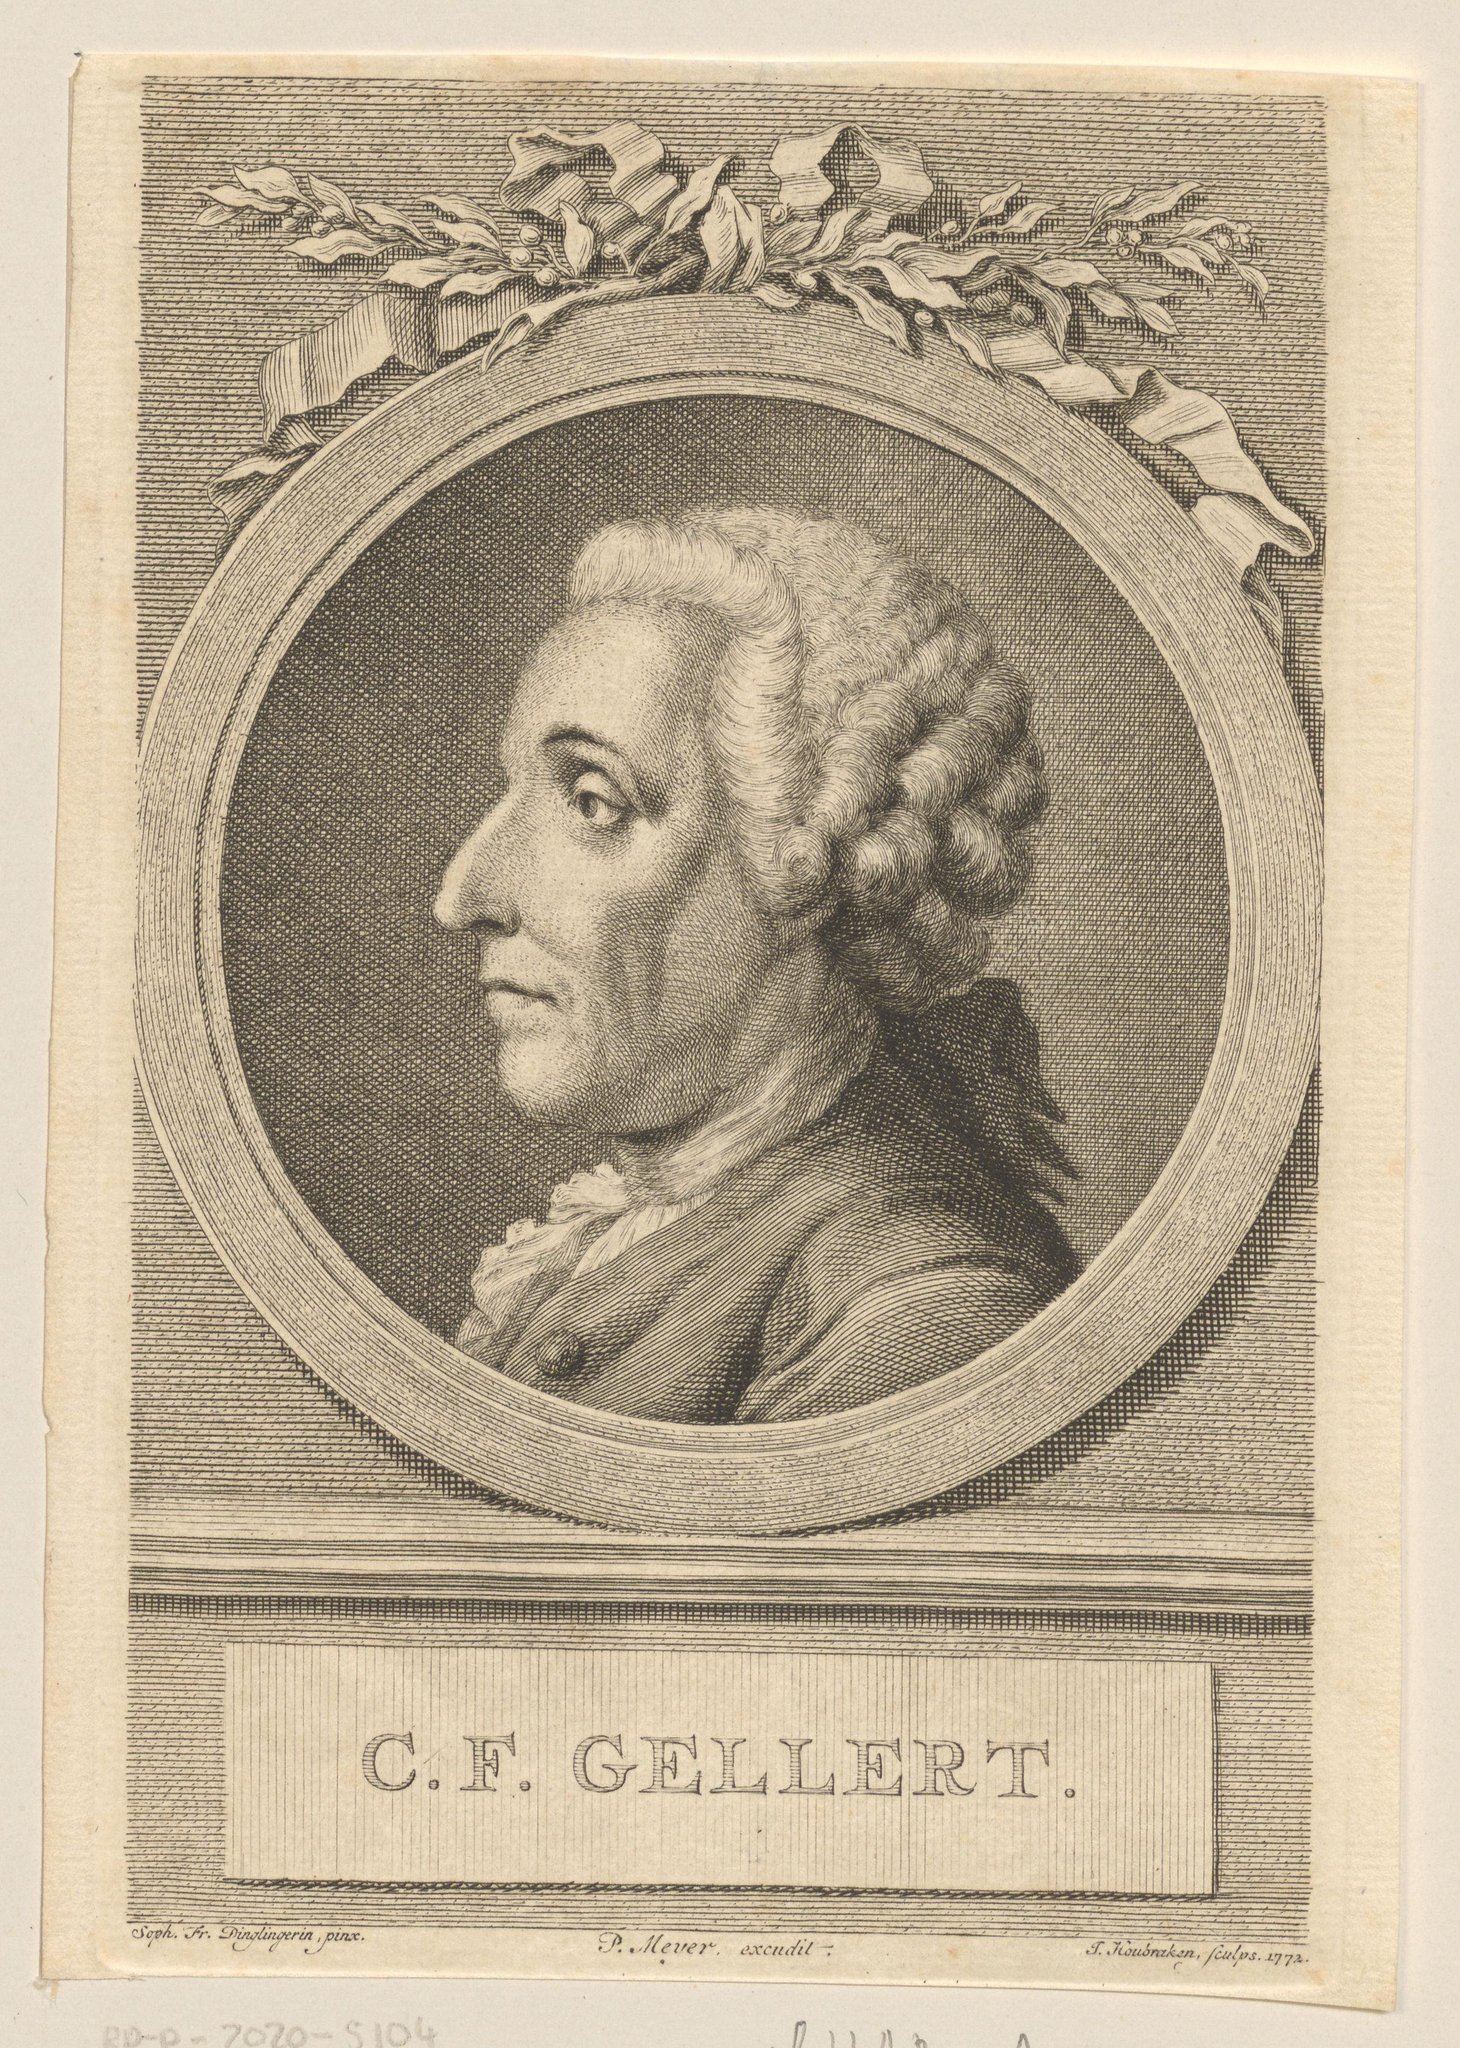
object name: print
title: Portret van Christian Furchtegott Gellert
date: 1772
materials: paper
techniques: engraving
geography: amsterdam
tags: historical persons, writer, poet, author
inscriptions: date